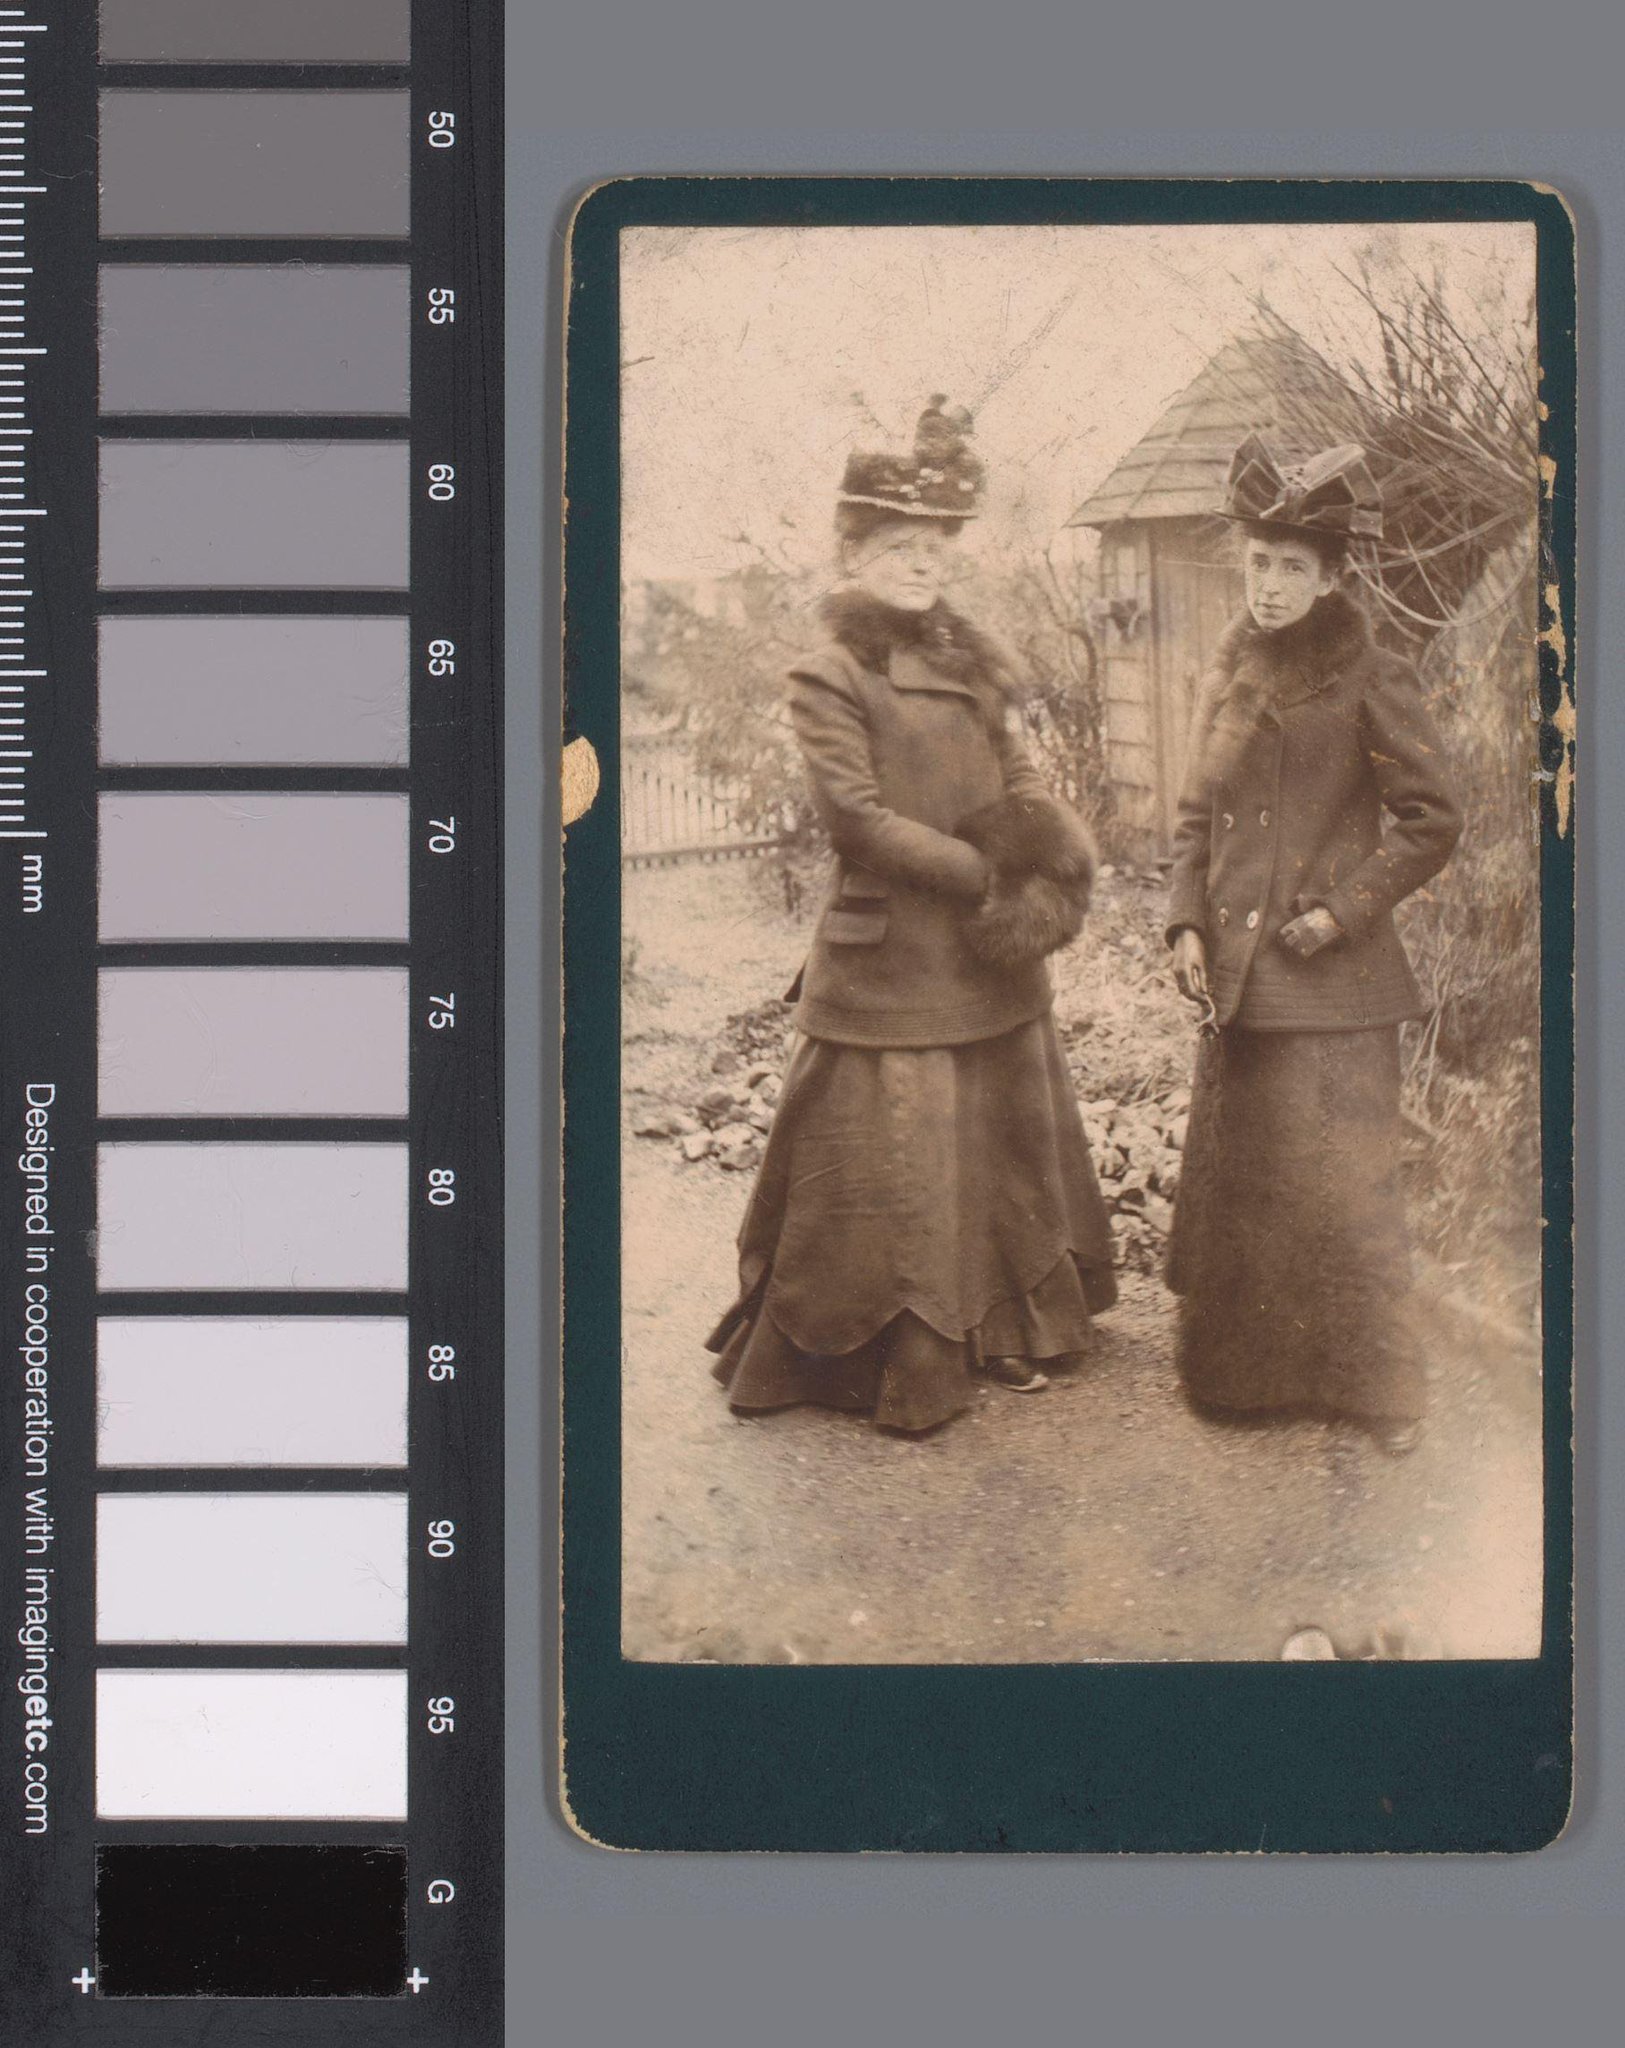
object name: photograph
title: Portret van Julia Bryant en Emilia Garelli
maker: Anonymous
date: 1900-1914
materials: paper, cardboard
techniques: gelatin silver print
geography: england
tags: adult woman, historical persons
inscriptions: inscription: ‘Julia Bryant/ Emilia Garelli’, inscription: ‘Aunties friend/ Julia Bryant/ & Auntie Emmie,/ in Abridge garden’